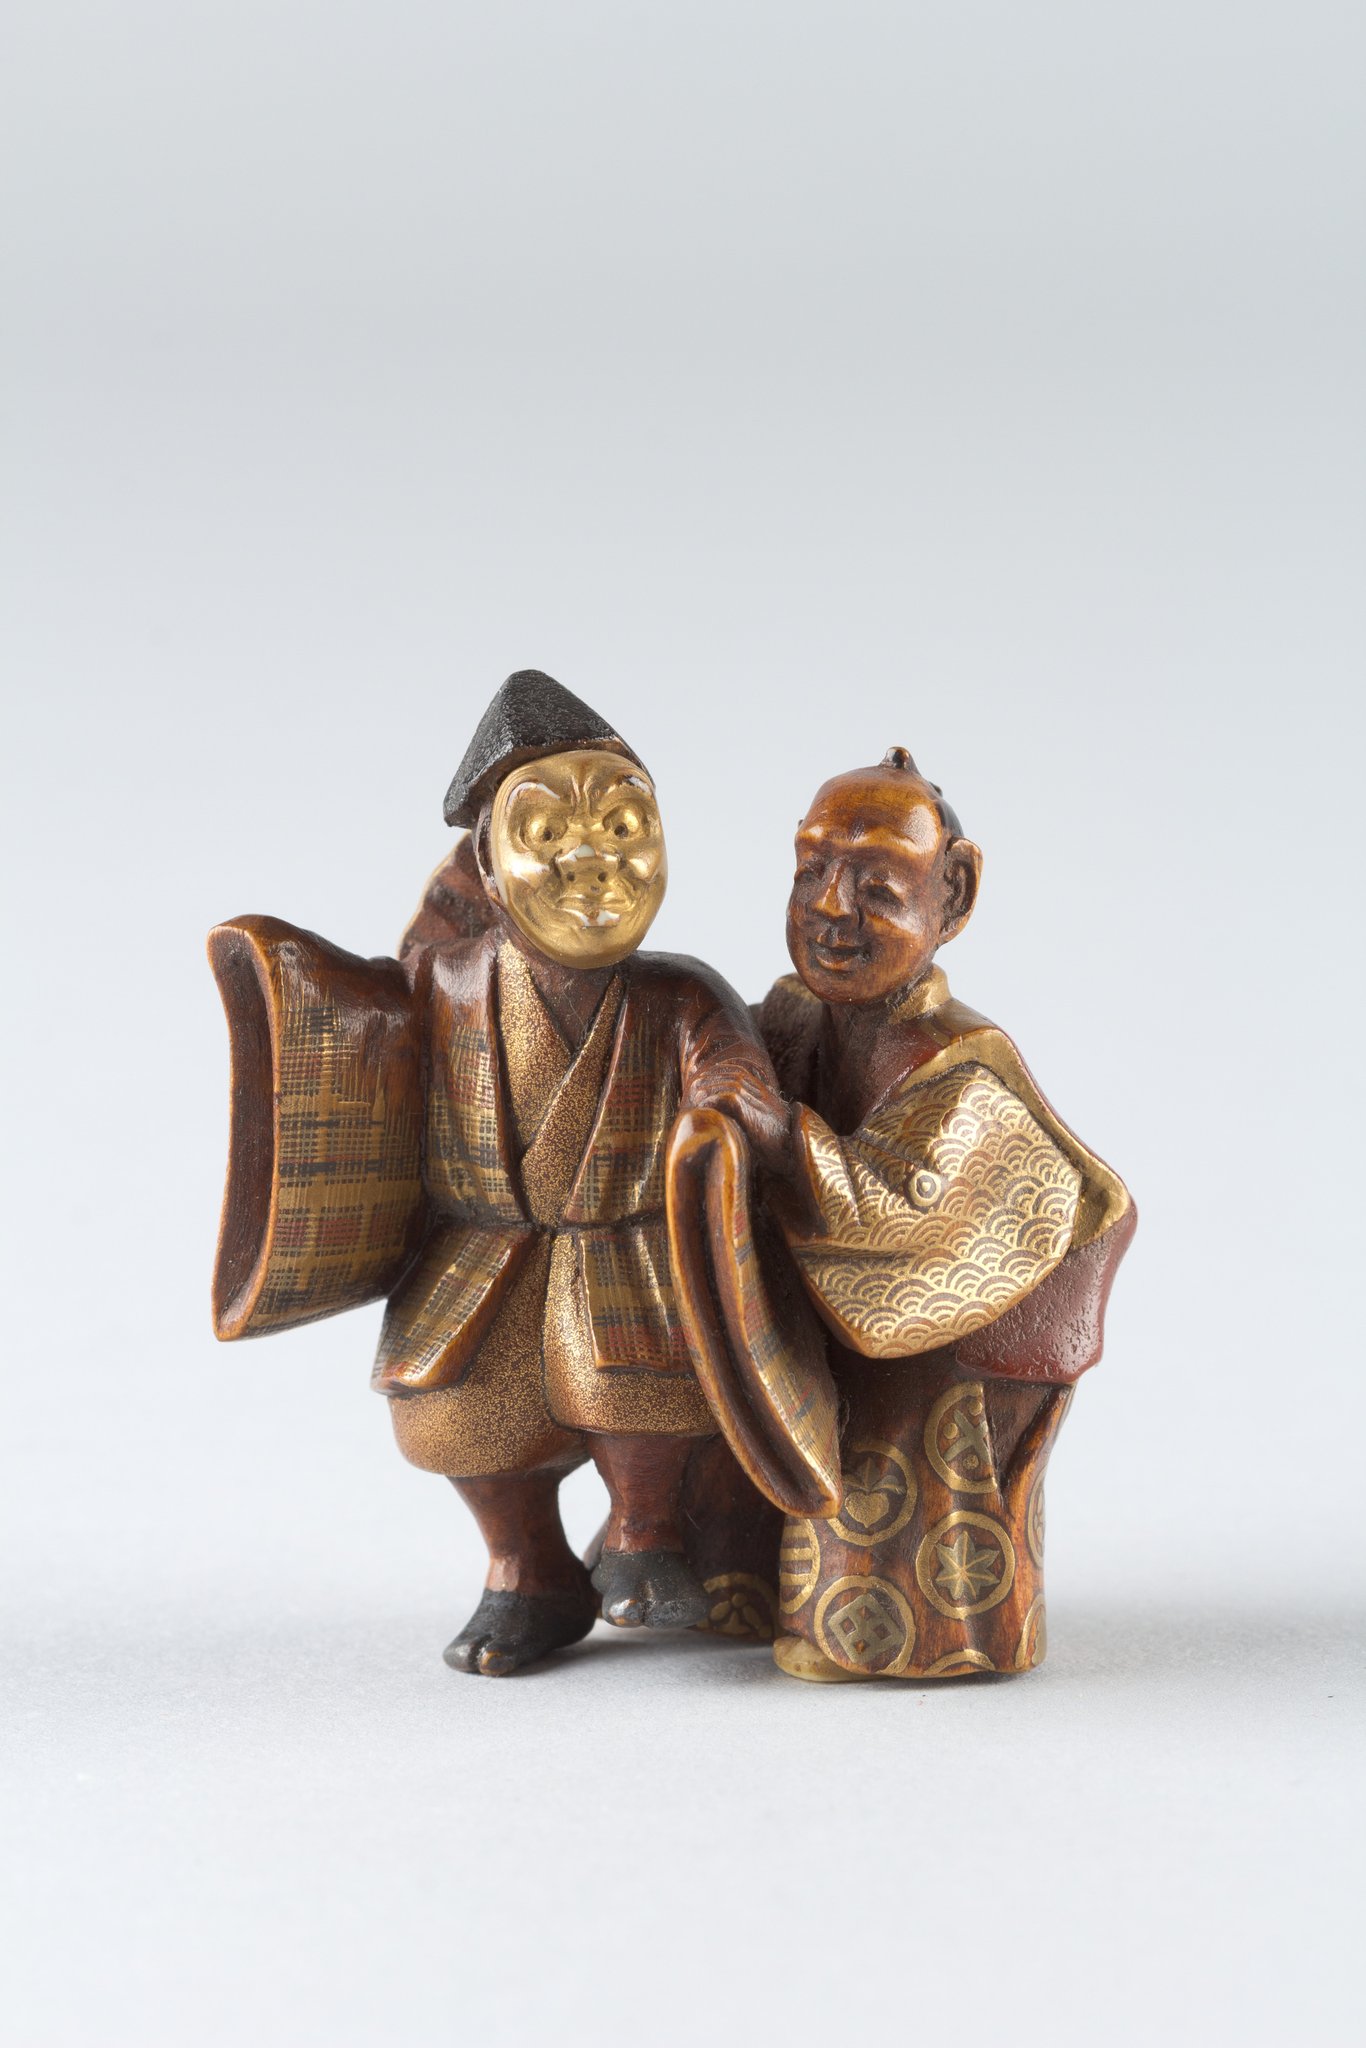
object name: netsuke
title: Netsuke of Two Noh Dancers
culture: japanese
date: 1801-1900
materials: lacquer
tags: men,dancers